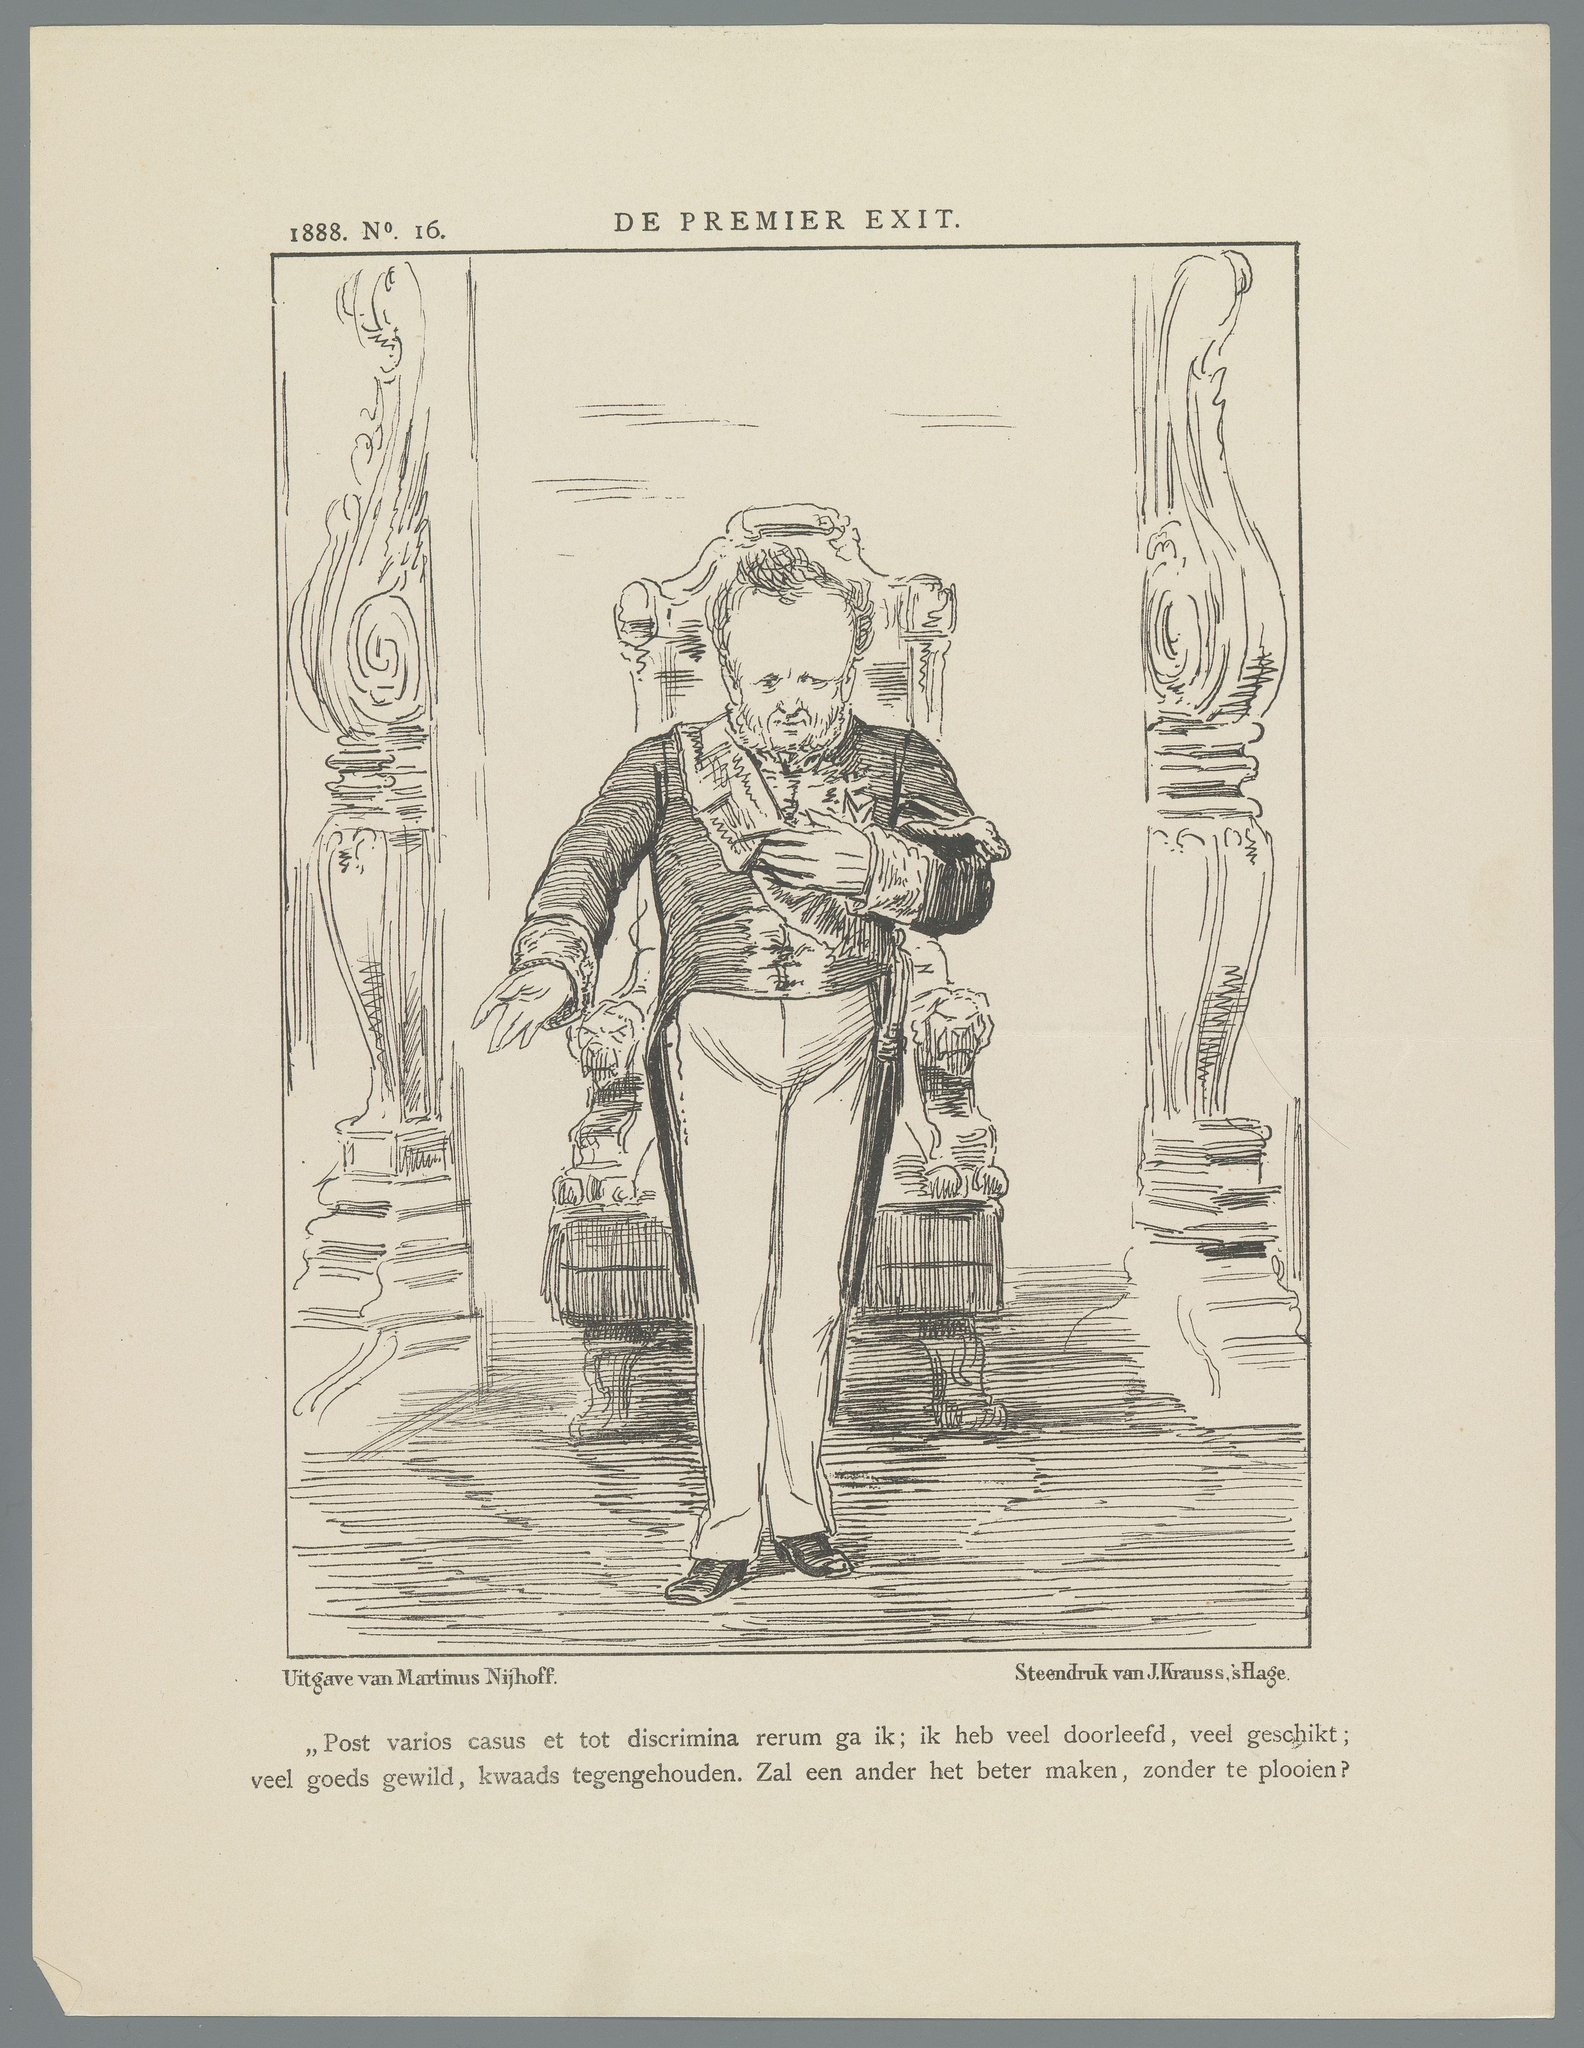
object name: cartoon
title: Spotprent bij het vertrek van minister Heemskerk, 1888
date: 1888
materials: paper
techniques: lithograph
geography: the hague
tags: amsterdam, politician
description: Spotprent bij het vertrek van minister Heemskerk. Plaat verschenen bij het weekblad De Nederlandsche Spectator, nr. 16, 1888.